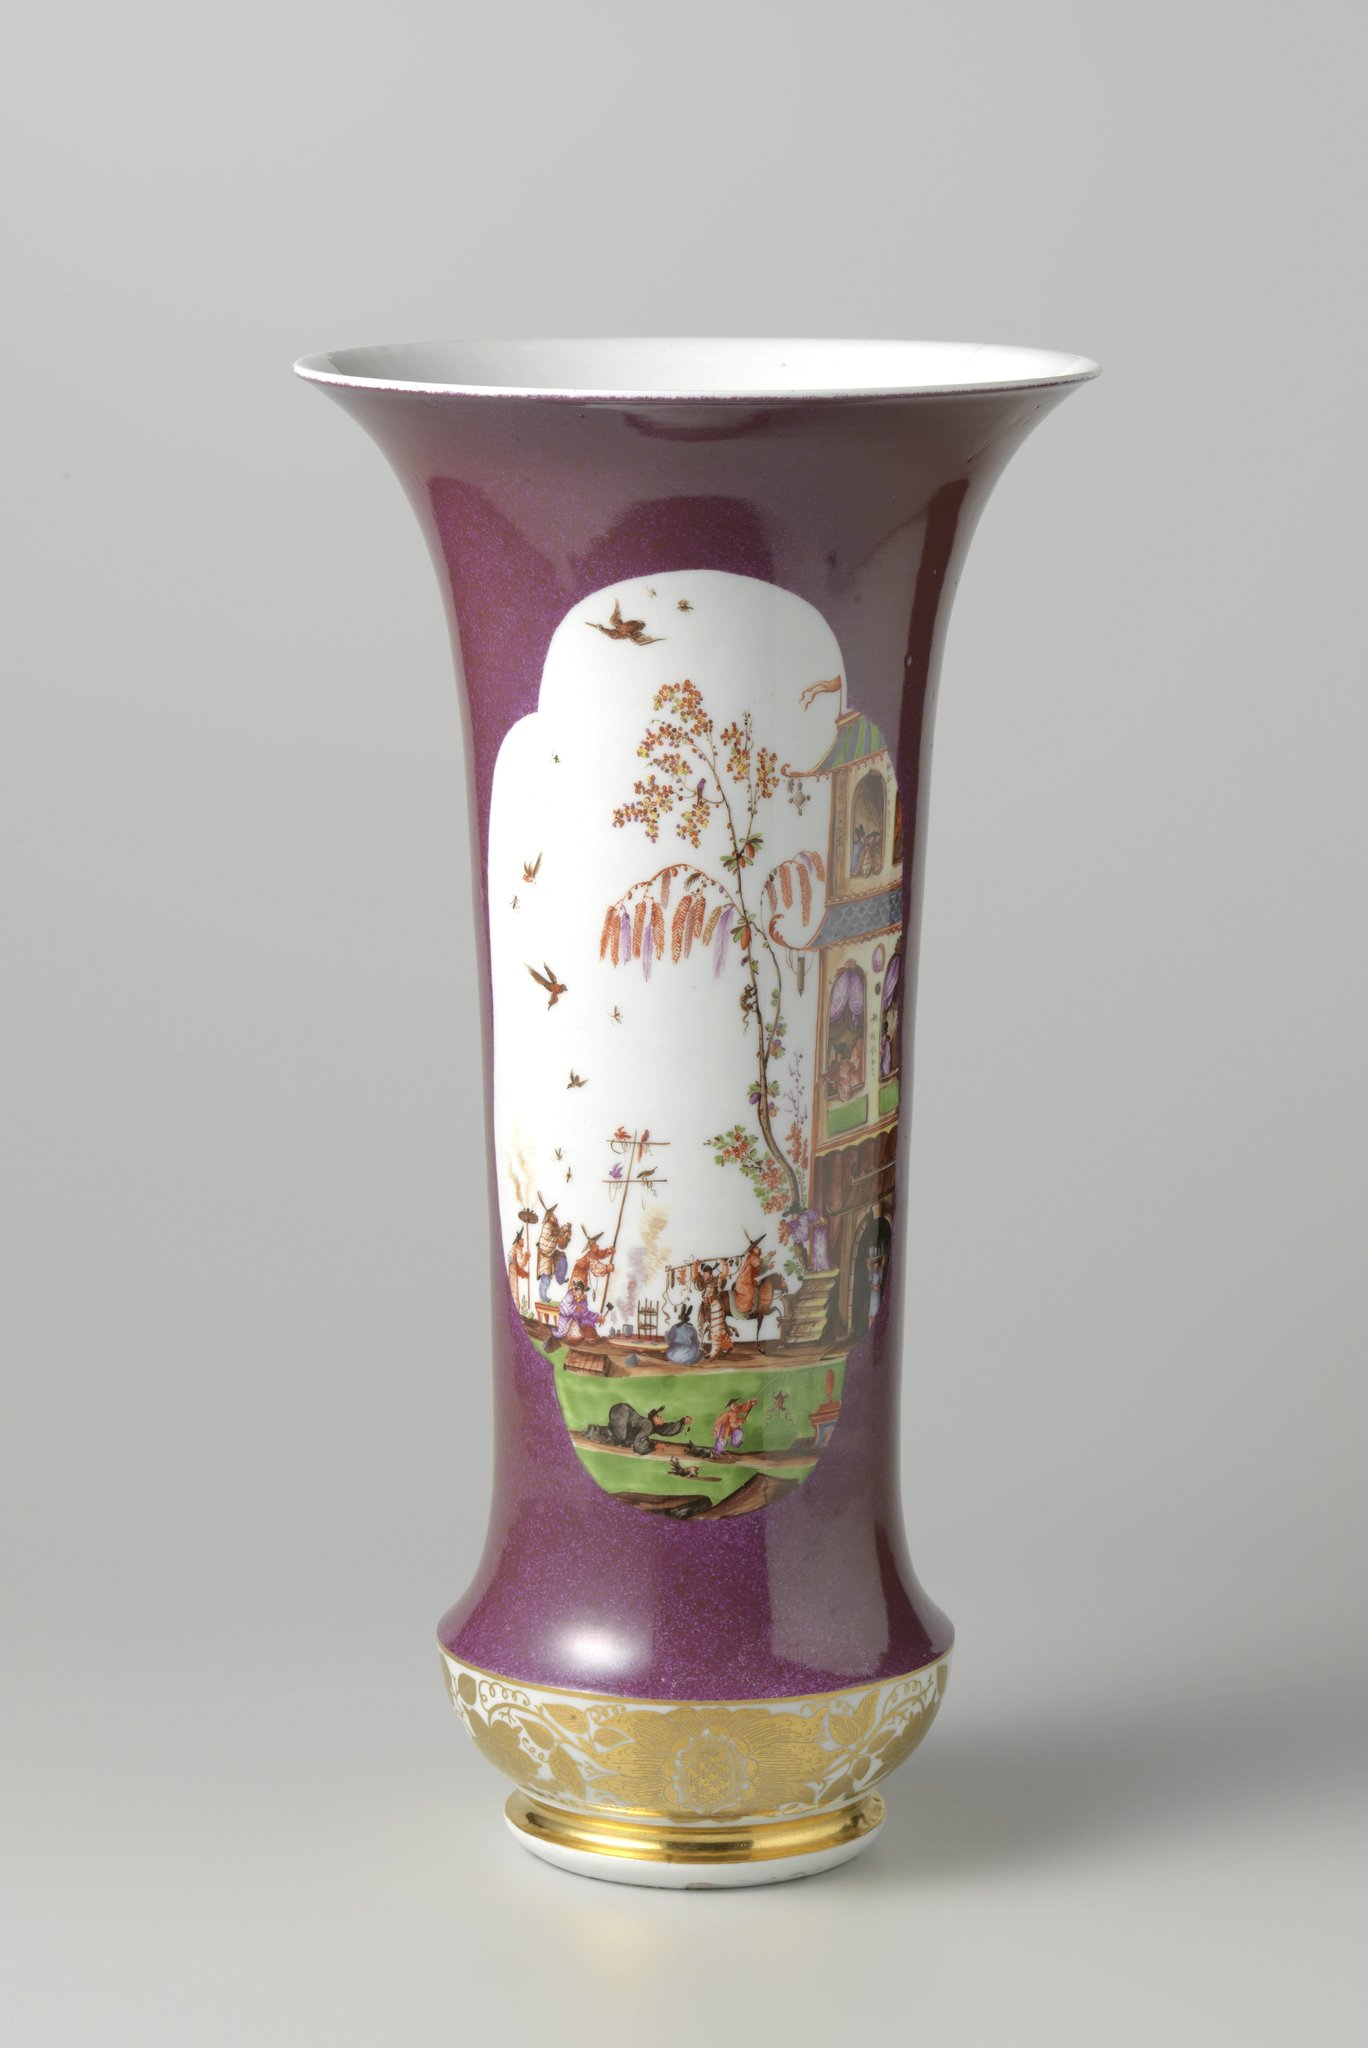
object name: vase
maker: johann herolt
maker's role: porseleinschilder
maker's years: 1696-1775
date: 1727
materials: porcelain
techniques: painted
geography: meissen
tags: chinese (+ other cultural aspects)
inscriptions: factory mark: ‘AR’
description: This vase was probably given by Elector Augustus the Strong of Saxony to the Russian court in 1728.